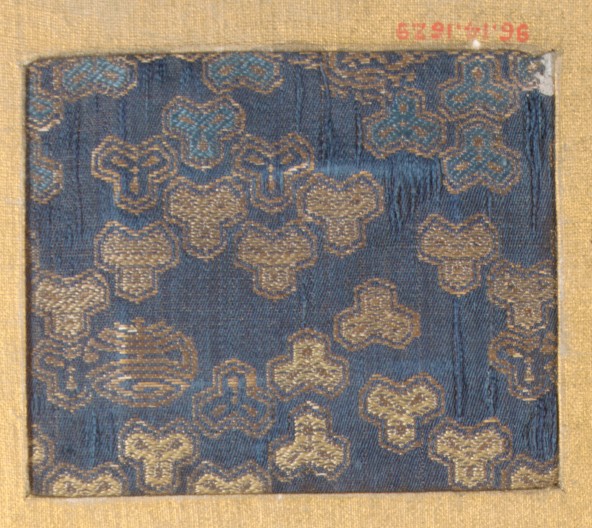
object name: piece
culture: japanese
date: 1701-1900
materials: silk